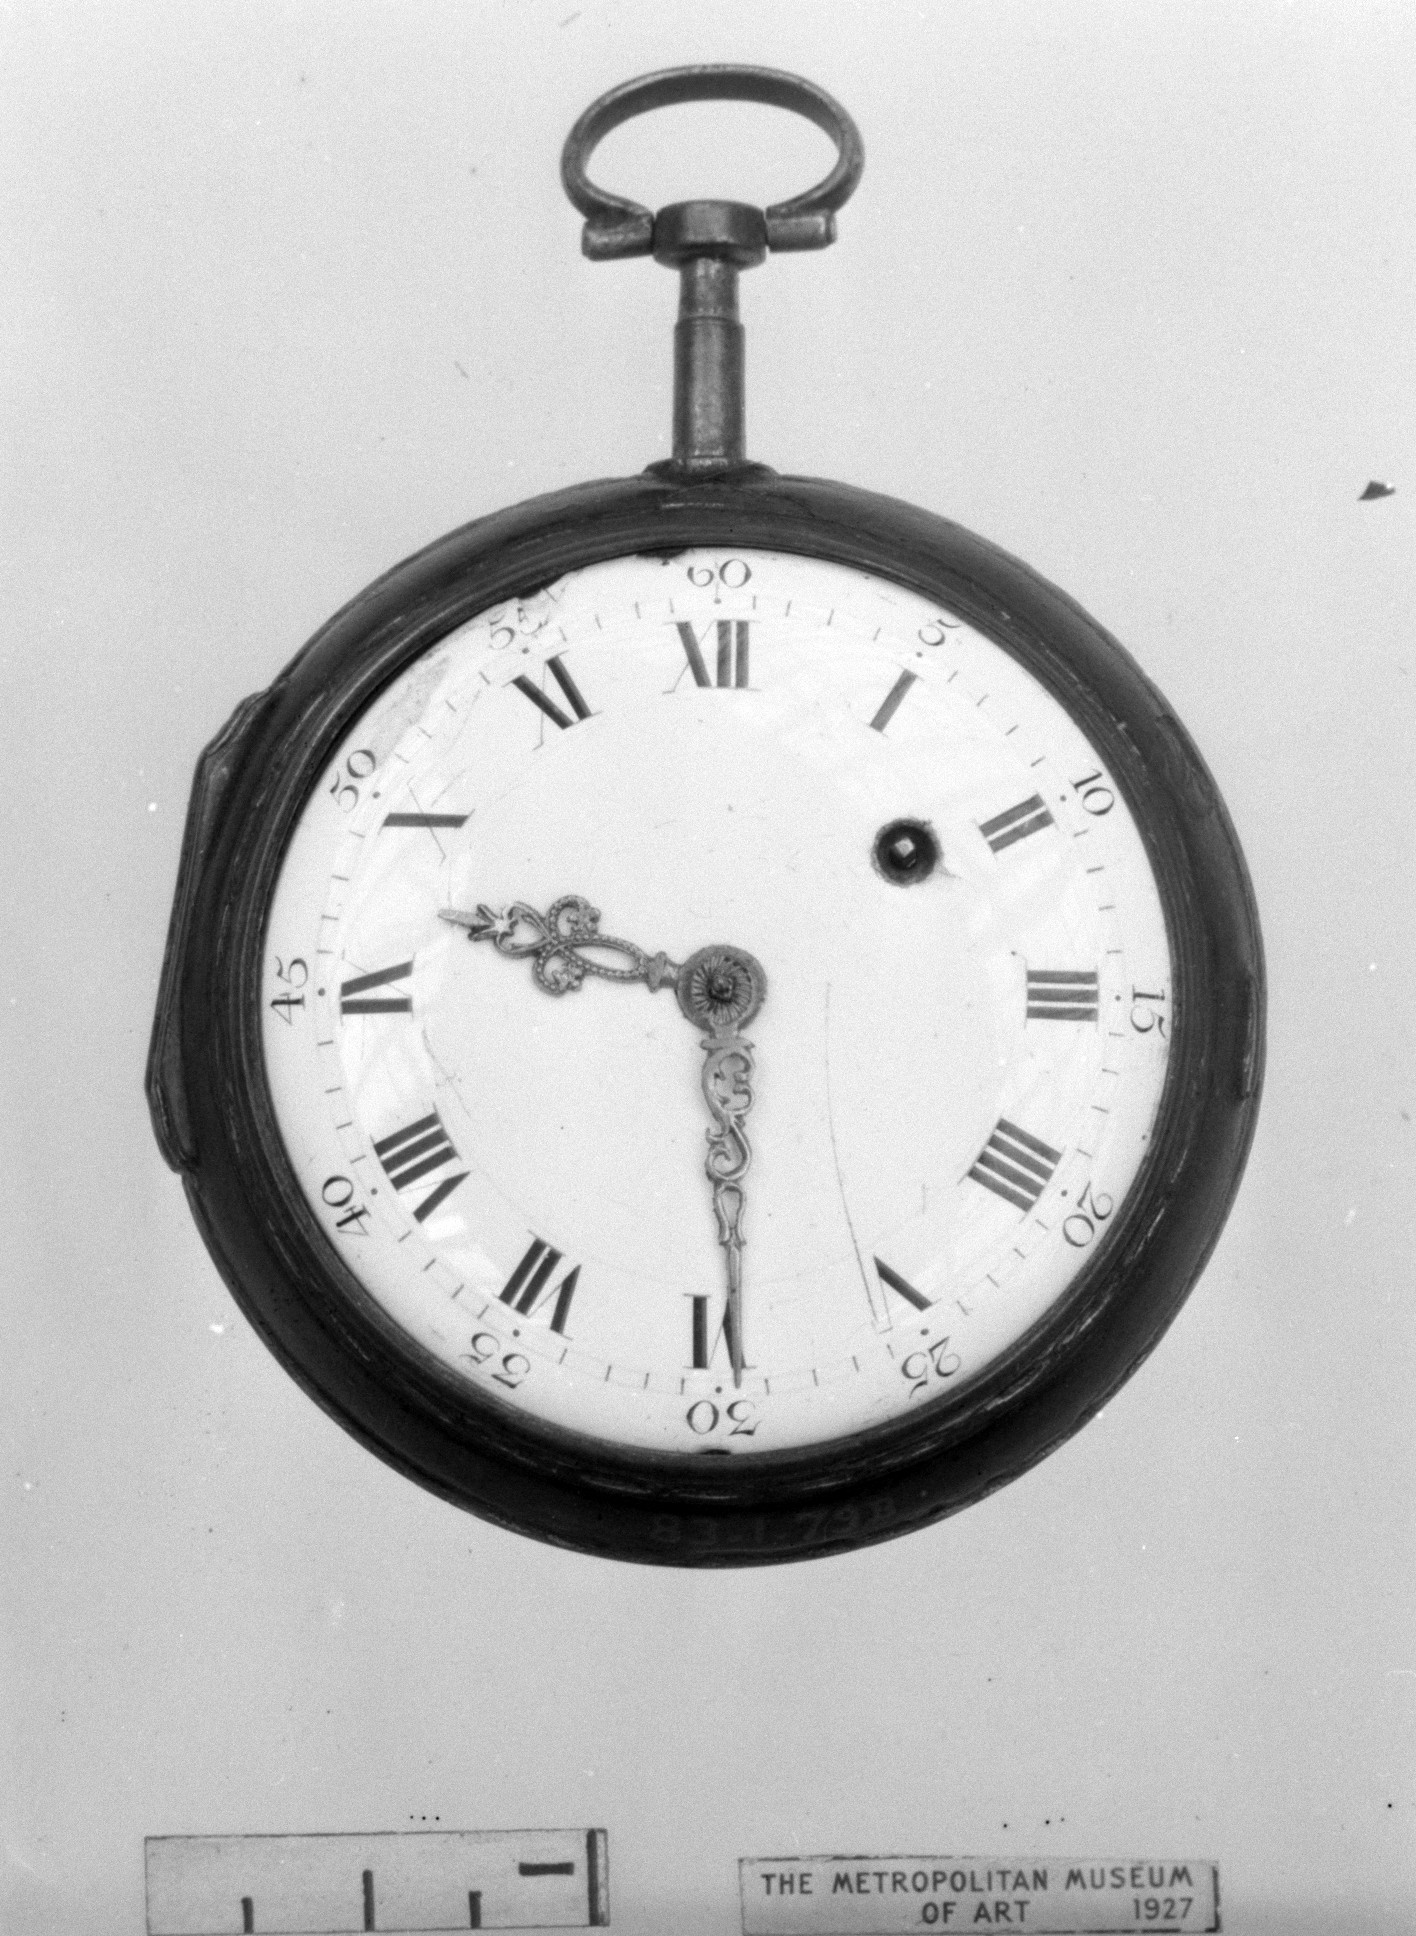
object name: watch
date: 1701-1800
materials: gilt copper, enamel